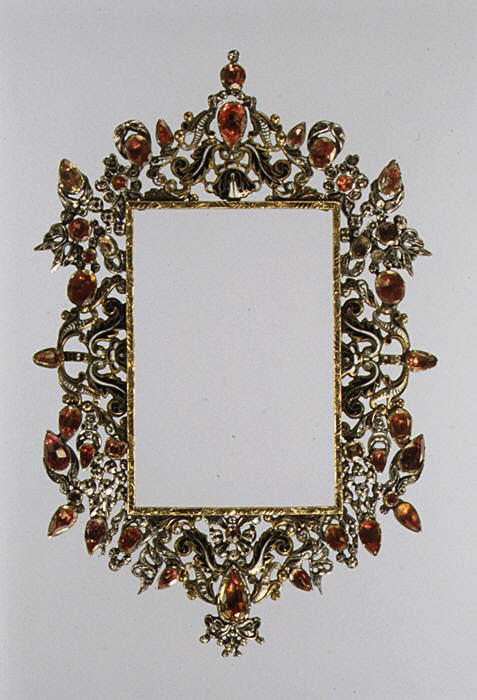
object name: frame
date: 1667-1733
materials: foil, metal, silver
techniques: backing, enamel, gilding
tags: flowers